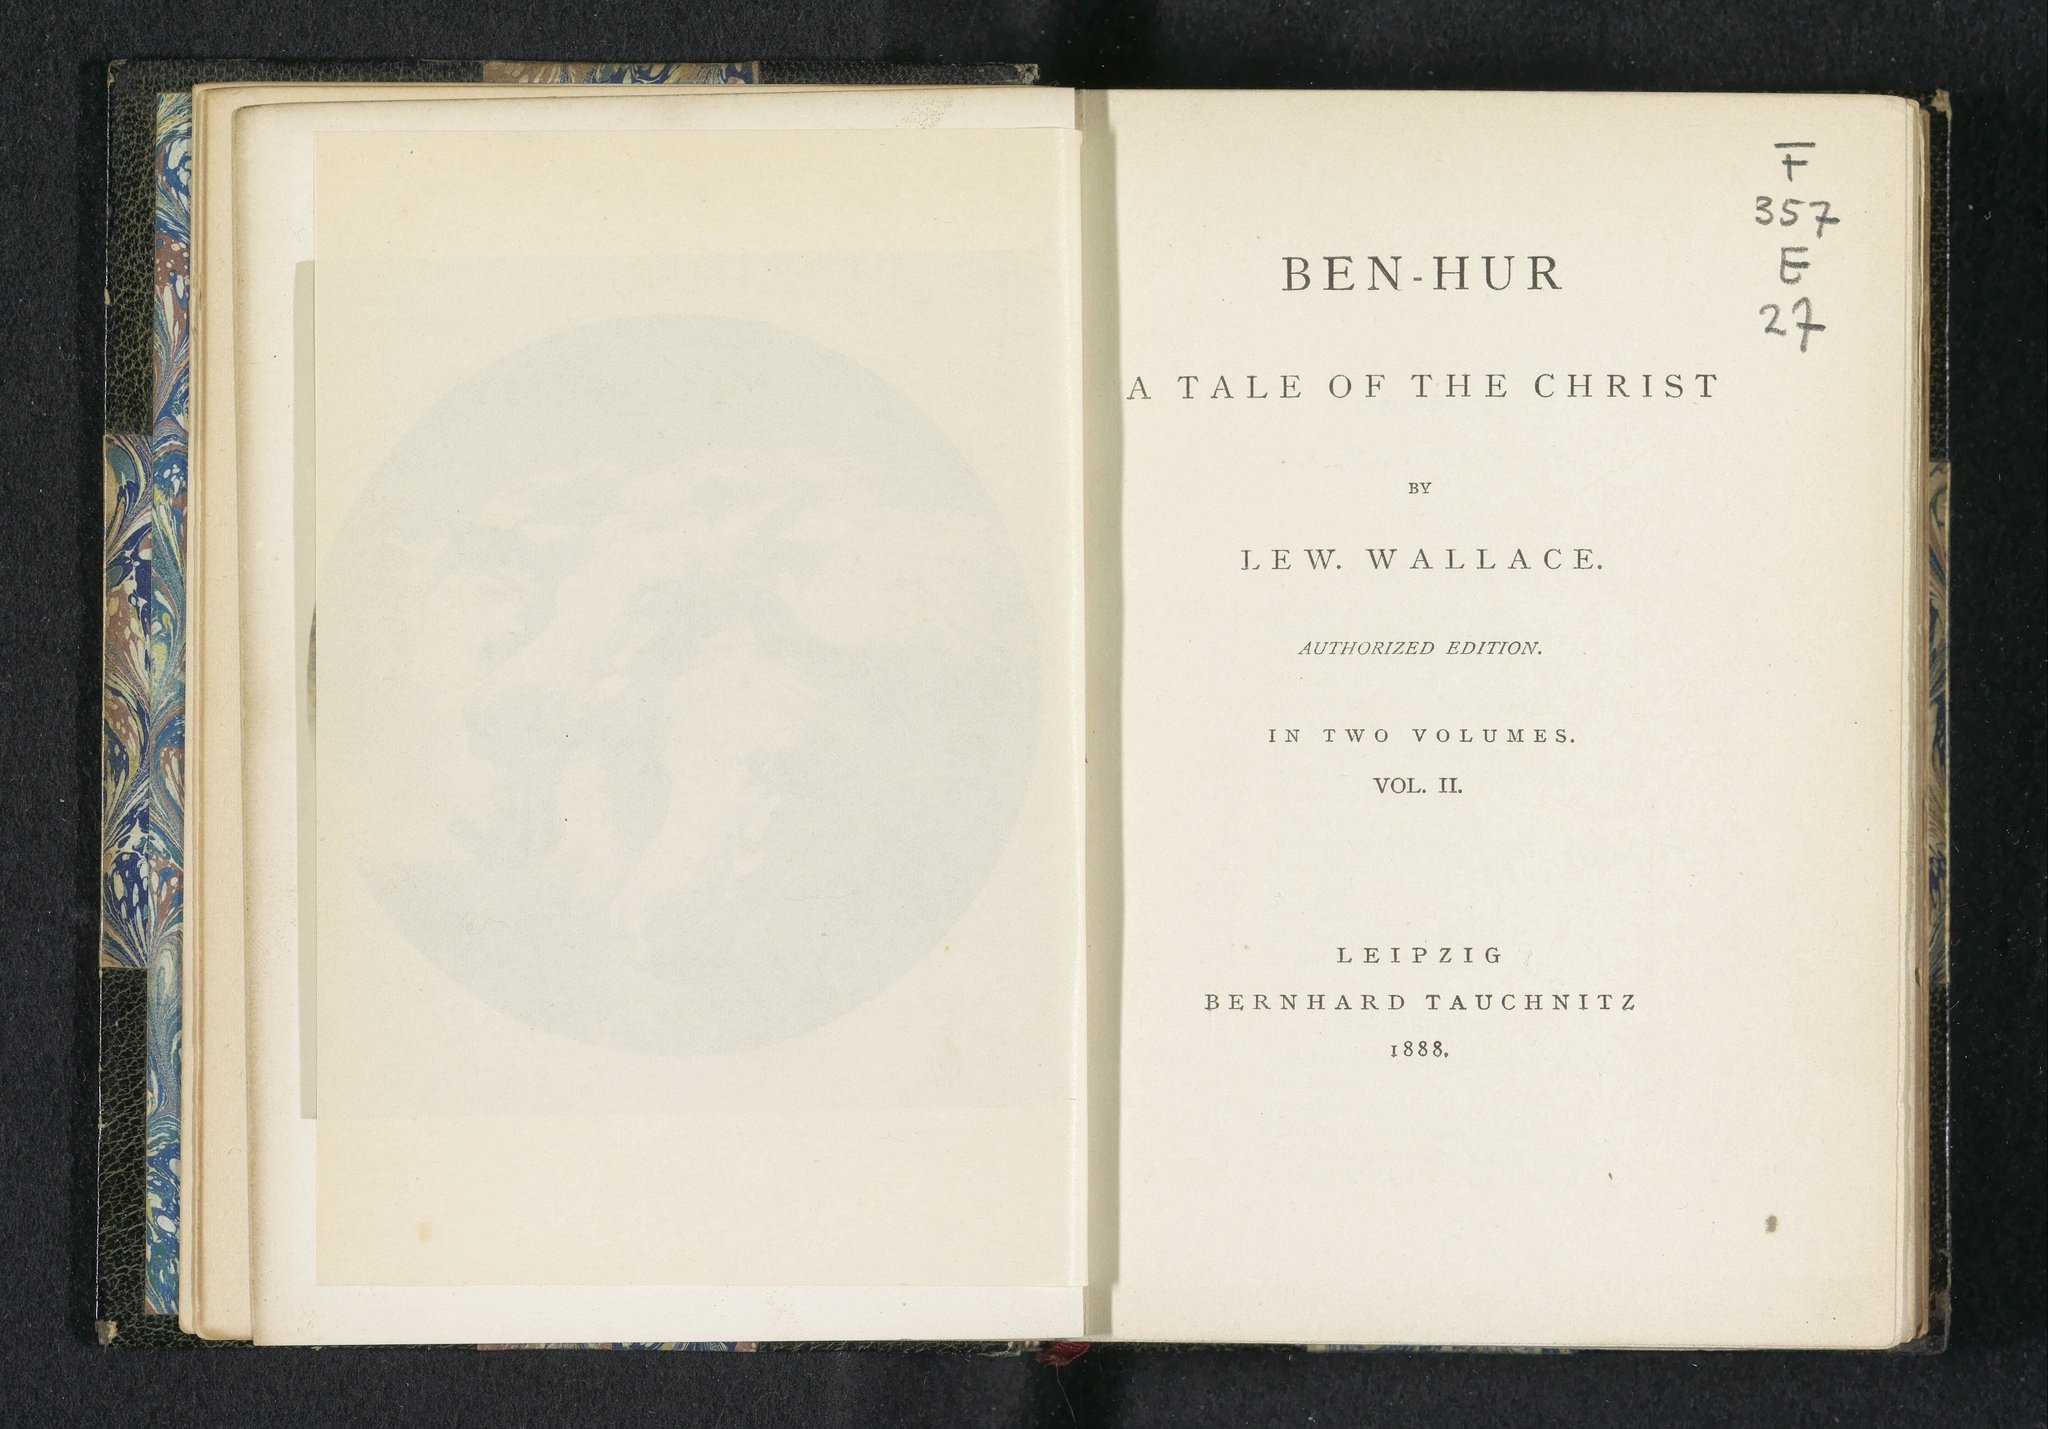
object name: book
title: Ben-Hur: a tale of the Christ vol. II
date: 1888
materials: cardboard, leather, paper, photographic support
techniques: albumen print, marbling, printing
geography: leipzig